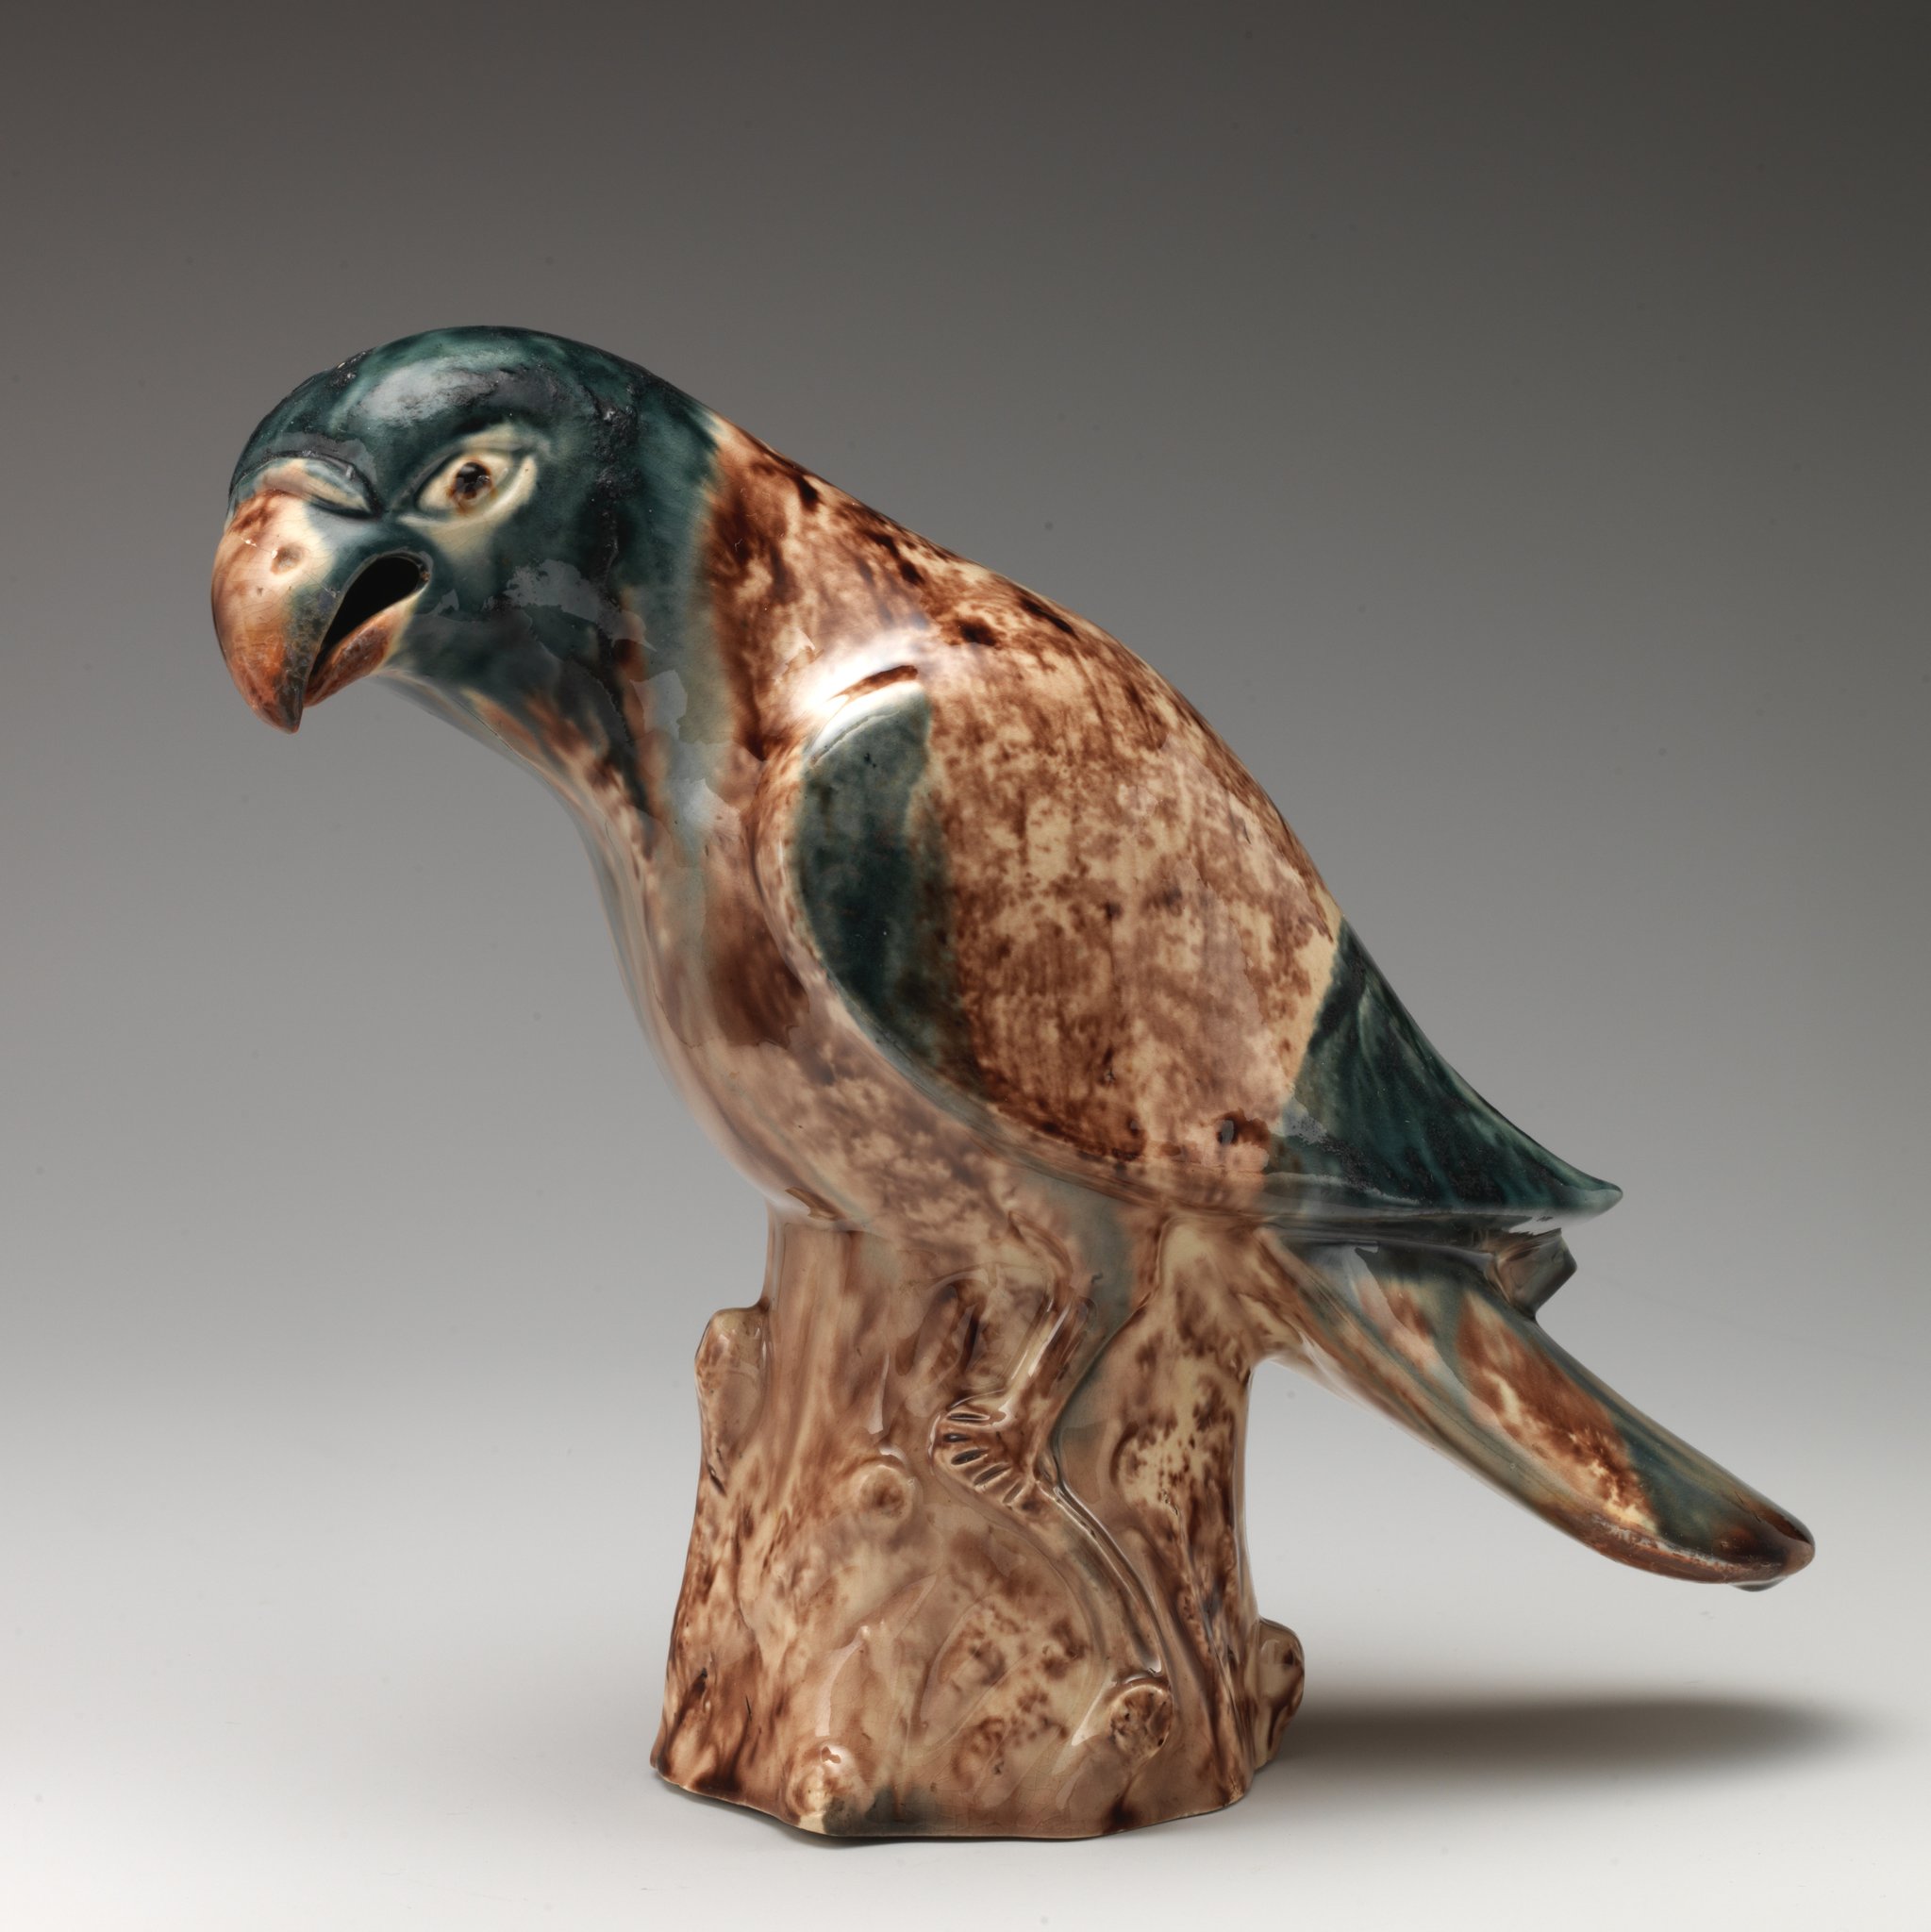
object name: figure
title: Parrot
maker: whieldon type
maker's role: maker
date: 1750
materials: earthenware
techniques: glazing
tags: parrots